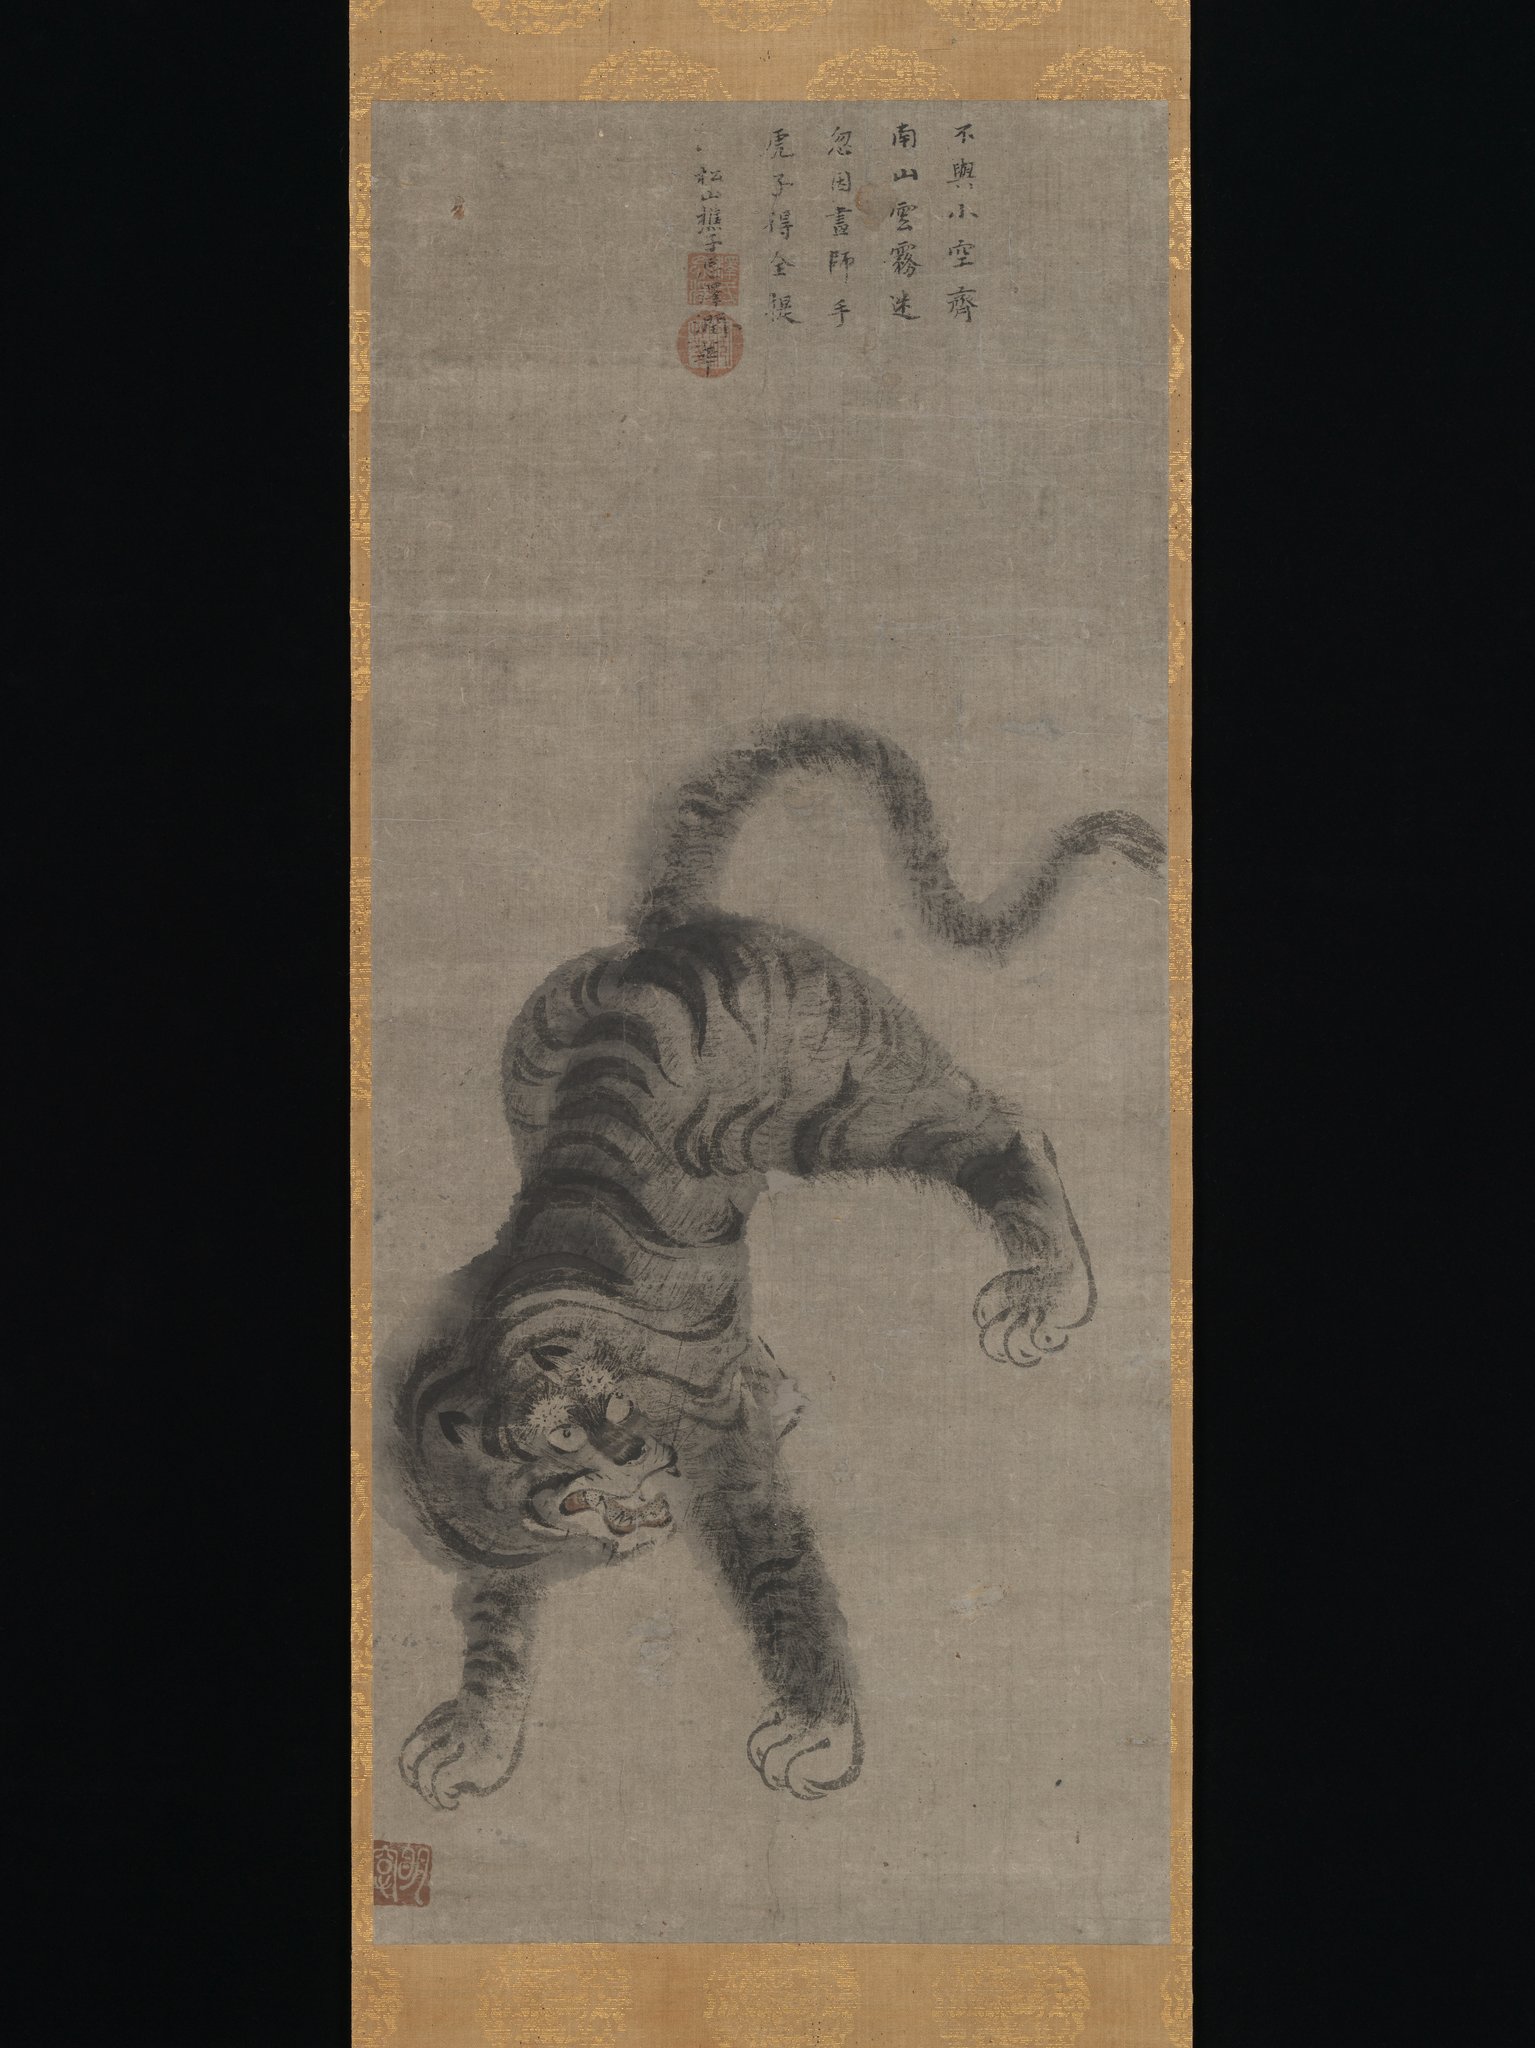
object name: hanging scroll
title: Tiger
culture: japanese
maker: meisō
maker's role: artist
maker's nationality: japanese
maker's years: 1700-1733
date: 1701-1733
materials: ink, paper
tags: tigers